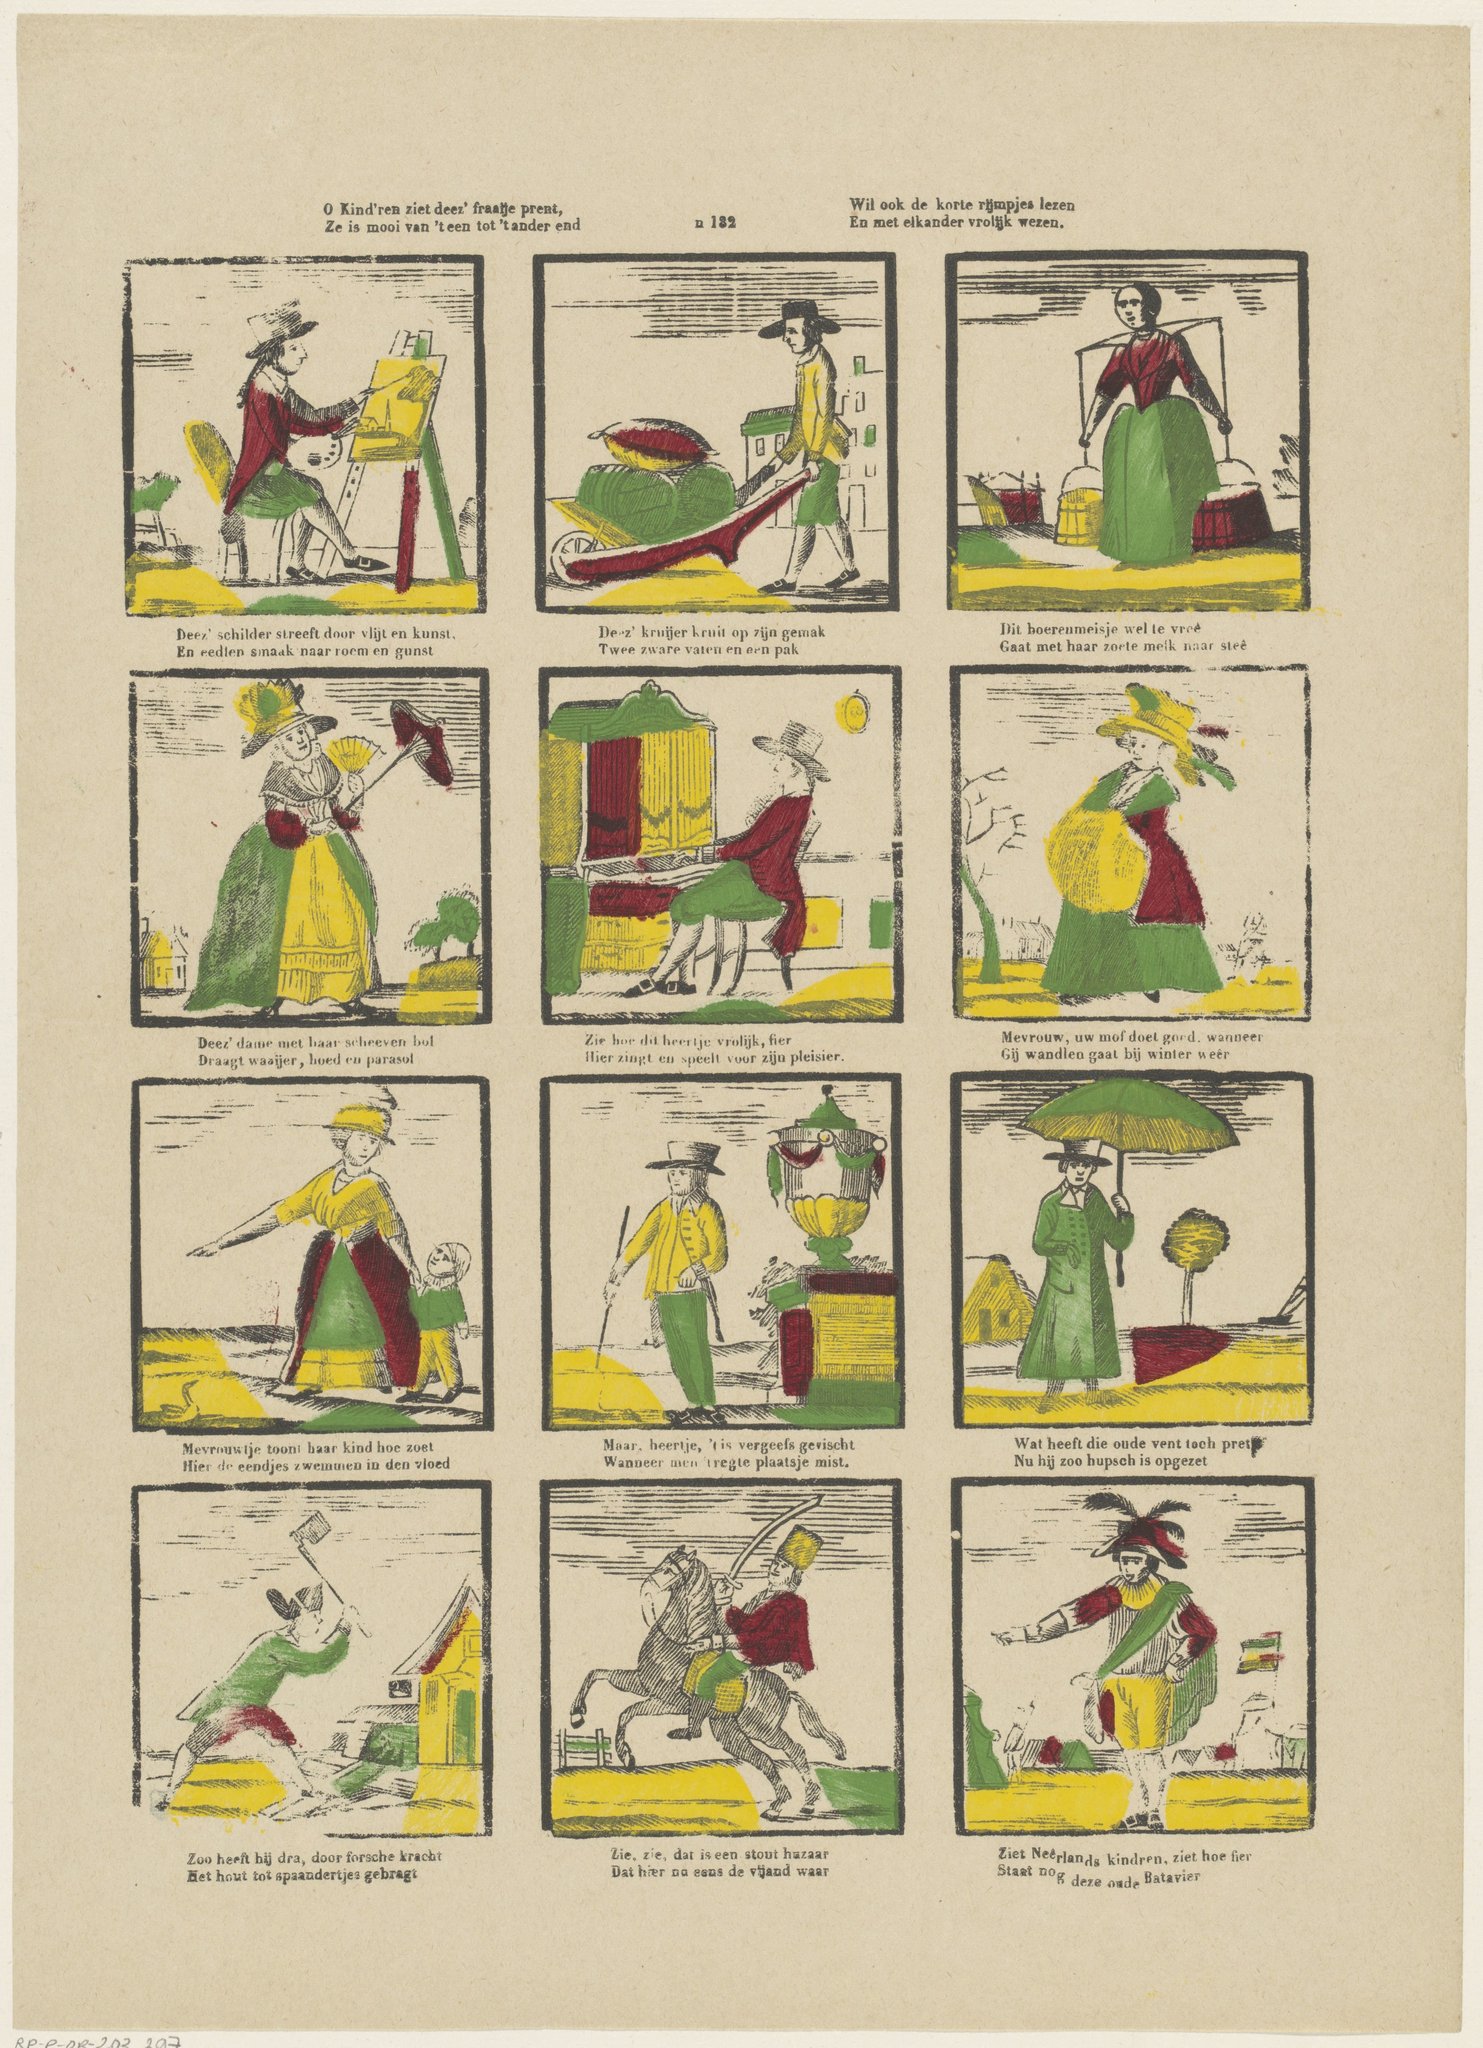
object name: print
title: O kind'ren ziet deez' fraaije prent, / Ze is mooi van 't een tot 't ander end / Wil ook de korte rijmpjes lezen / En met elkander vrolijk wezen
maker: Anonymous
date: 1833-1900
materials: paper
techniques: colour, letterpress printing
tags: riding a horse, ass, or mule; rider, horseman, musician at work, walking, hiking (recreation), painting ~ applied arts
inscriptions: collector's mark: Lugt 2760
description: Blad met 12 voorstellingen van verschillende bezigheden, waaronder schilderen, muziek maken en wandelen. Onder elke afbeelding een tweeregelig vers. Genummerd midden boven: n 132.